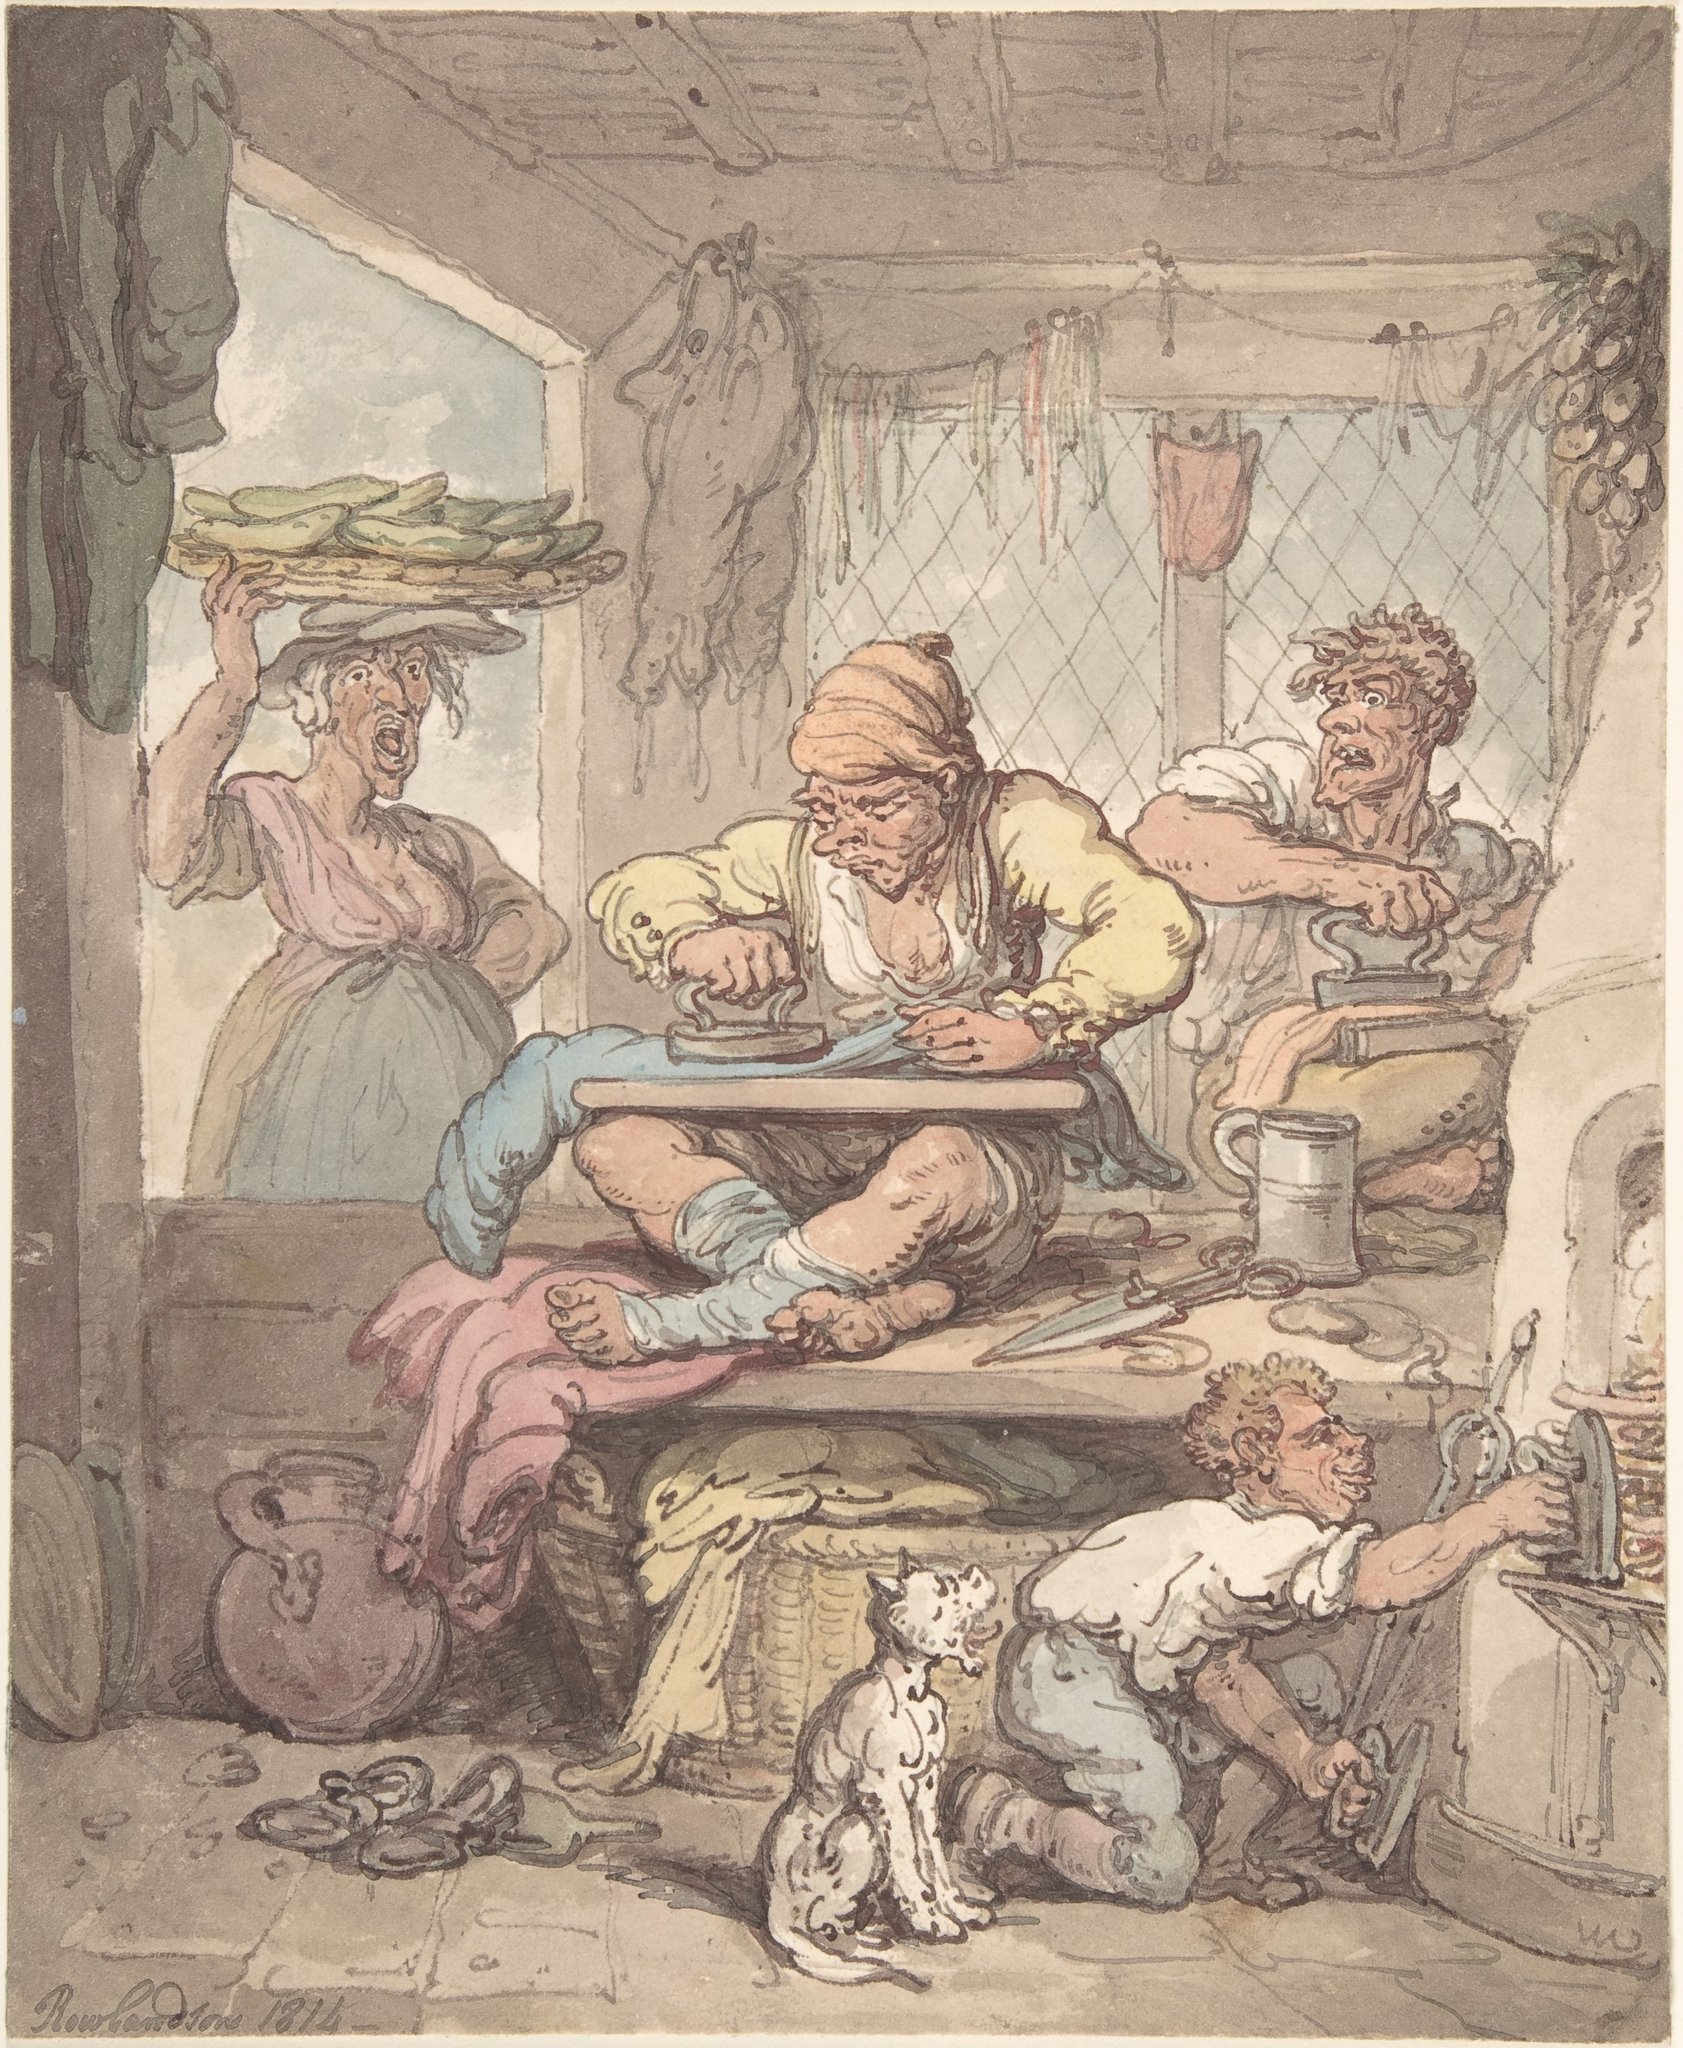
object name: drawing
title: The Tailor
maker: thomas rowlandson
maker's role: artist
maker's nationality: british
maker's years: 1757-1827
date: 1814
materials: ink, watercolor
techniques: pen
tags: boys,men,women,dogs,working